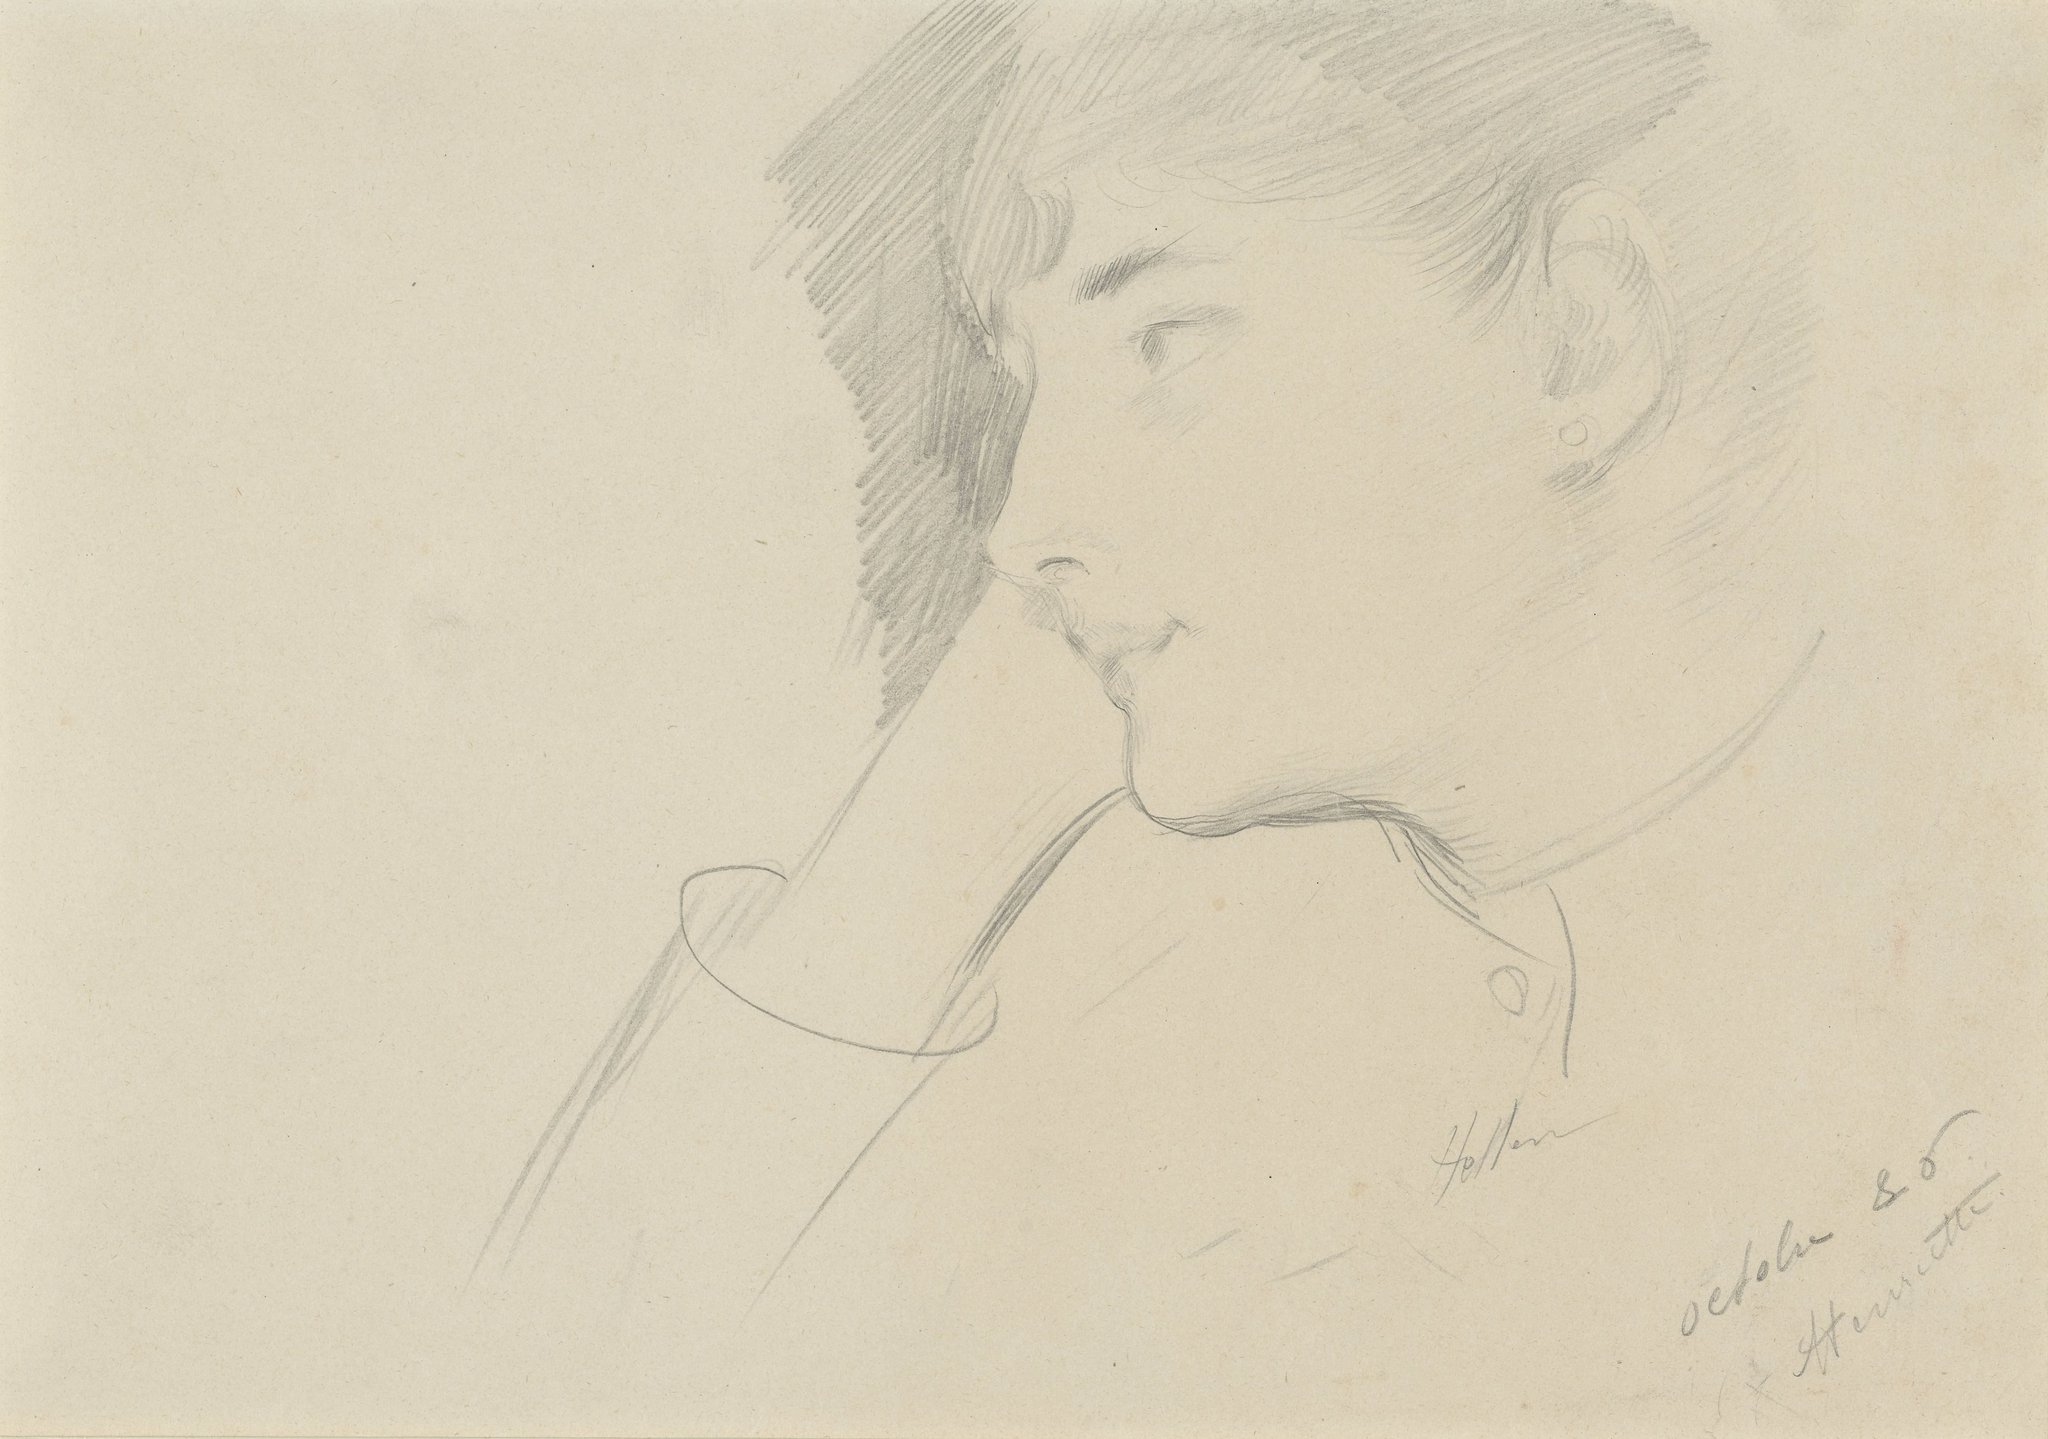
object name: drawing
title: Kop van een peinzende dame met het hoofd op de hand gesteund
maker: paul césar helleu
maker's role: draughtsman, painter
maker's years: 1859-1927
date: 1810-1886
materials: paper, pencil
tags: head held in the hand(s), with elbows leaning on an elevation or on the knees